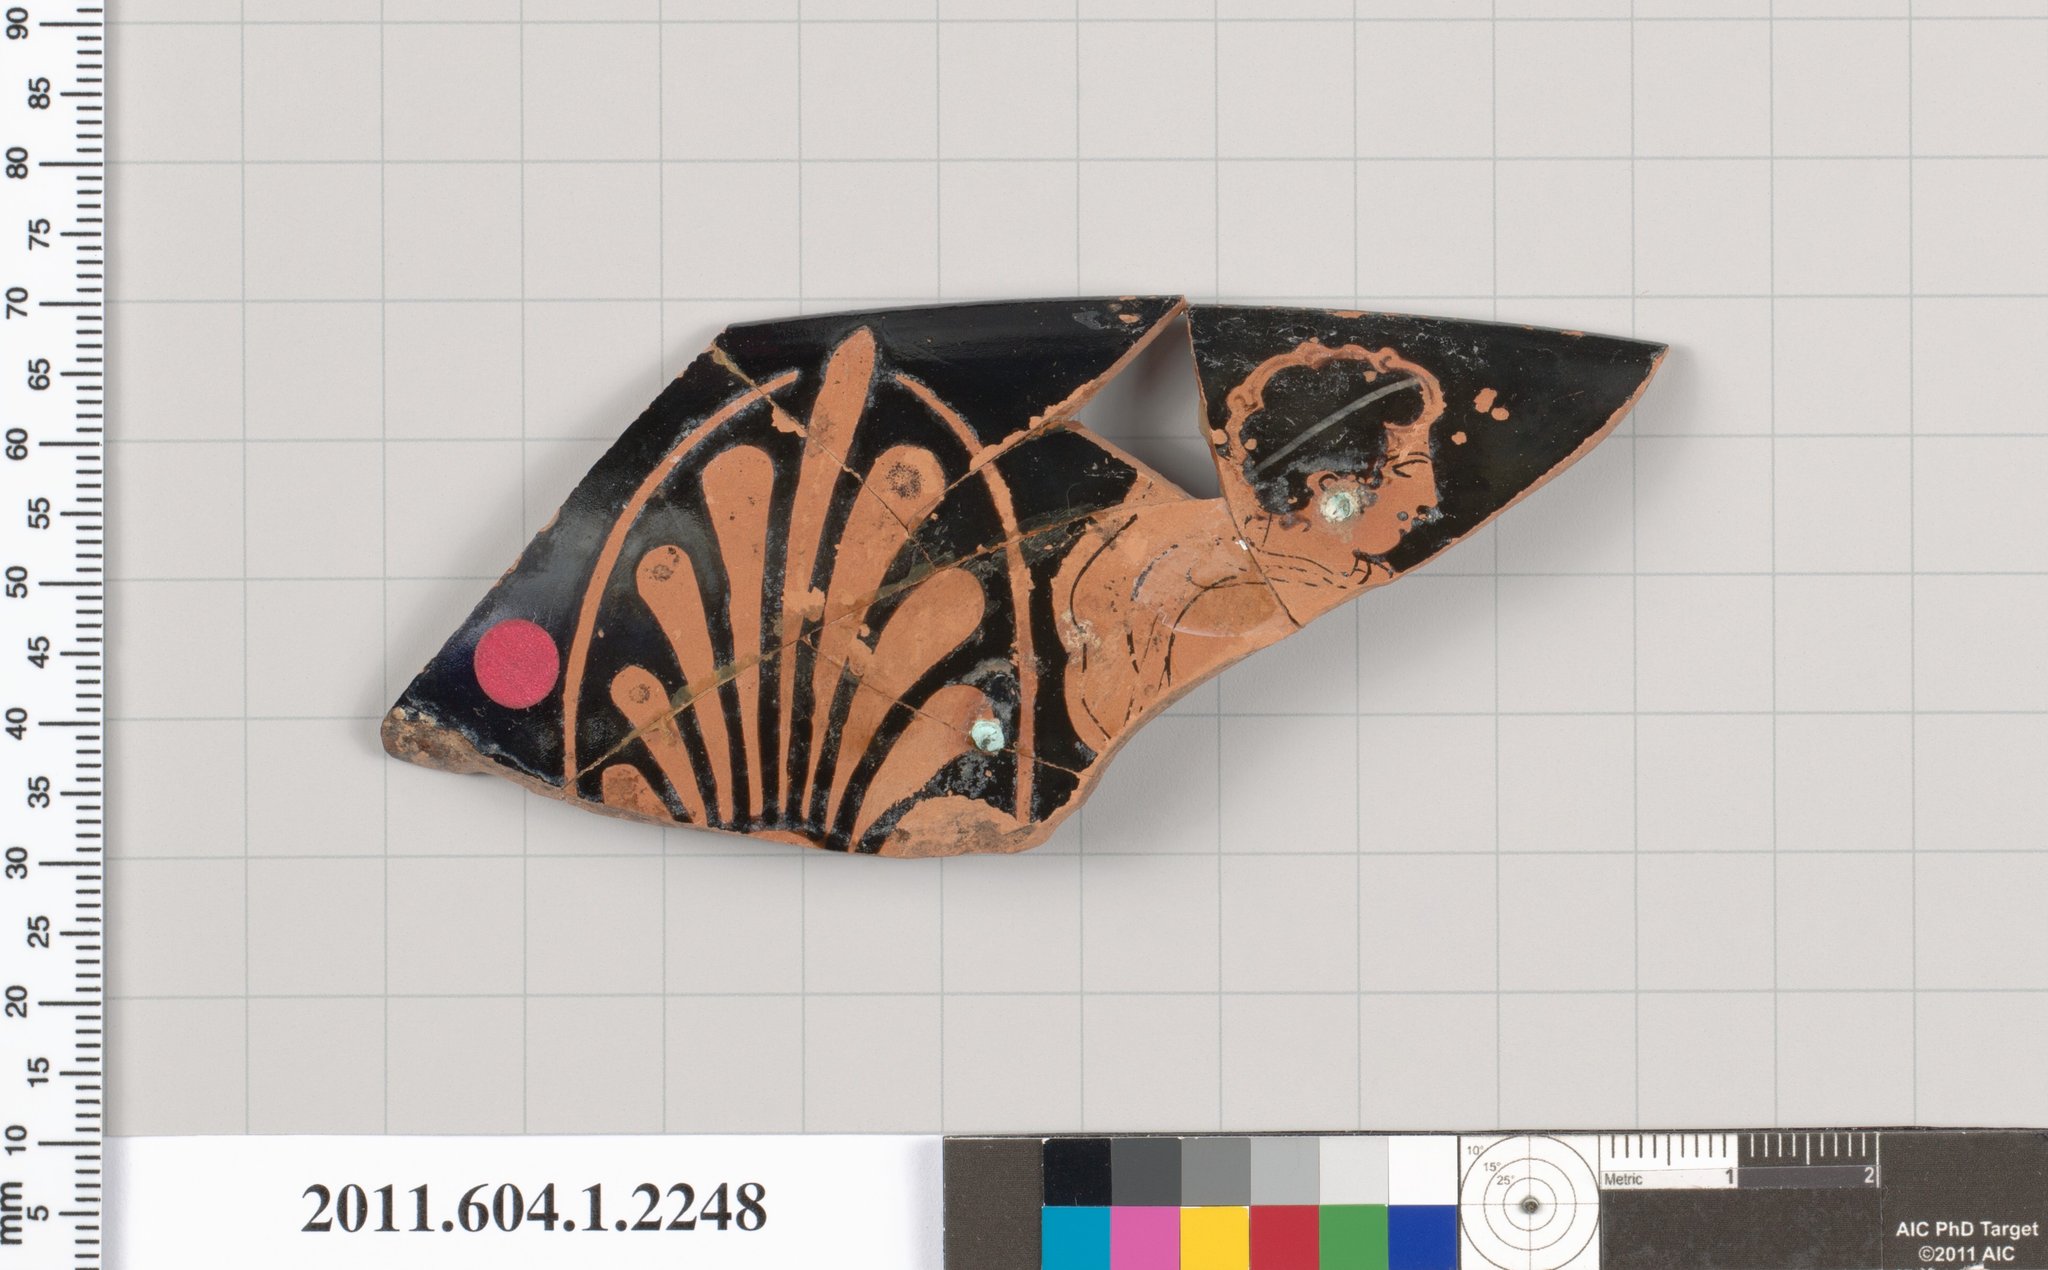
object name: kylix fragment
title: Terracotta rim fragment of a kylix (drinking cup)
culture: greek, attic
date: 467-435 BCE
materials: terracotta